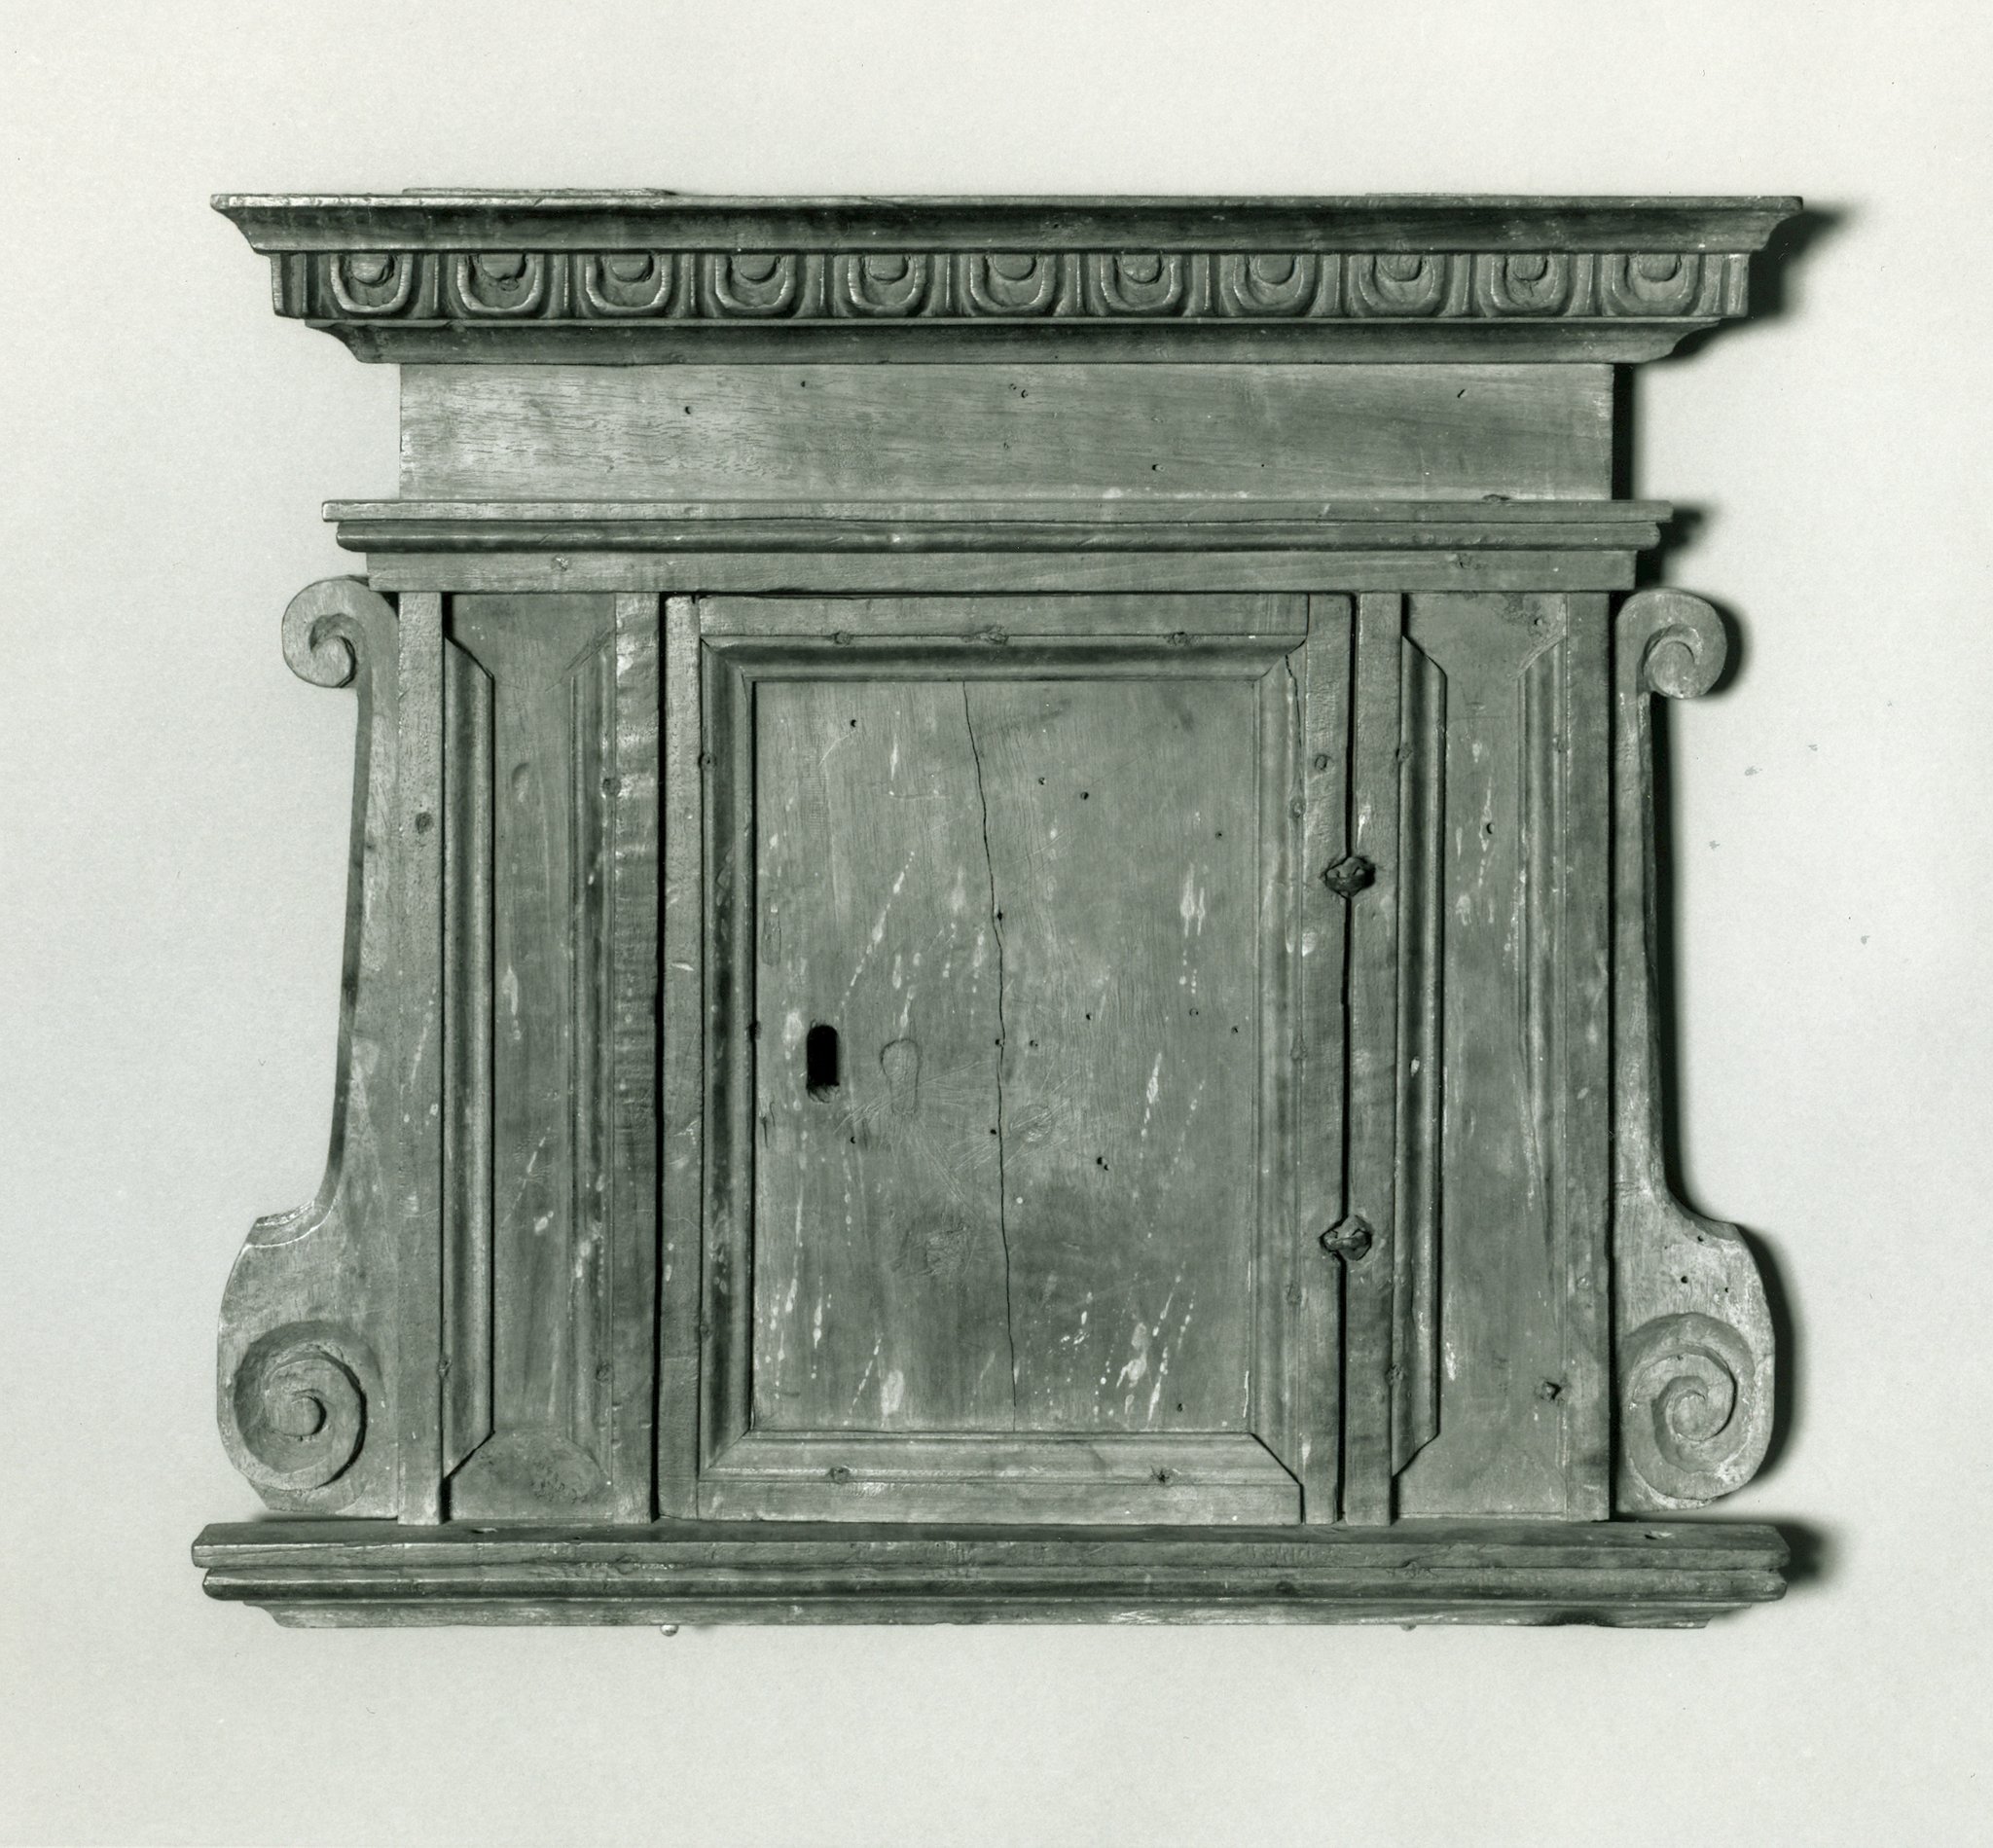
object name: door from a cupboard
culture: italian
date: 1667-1700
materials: wood